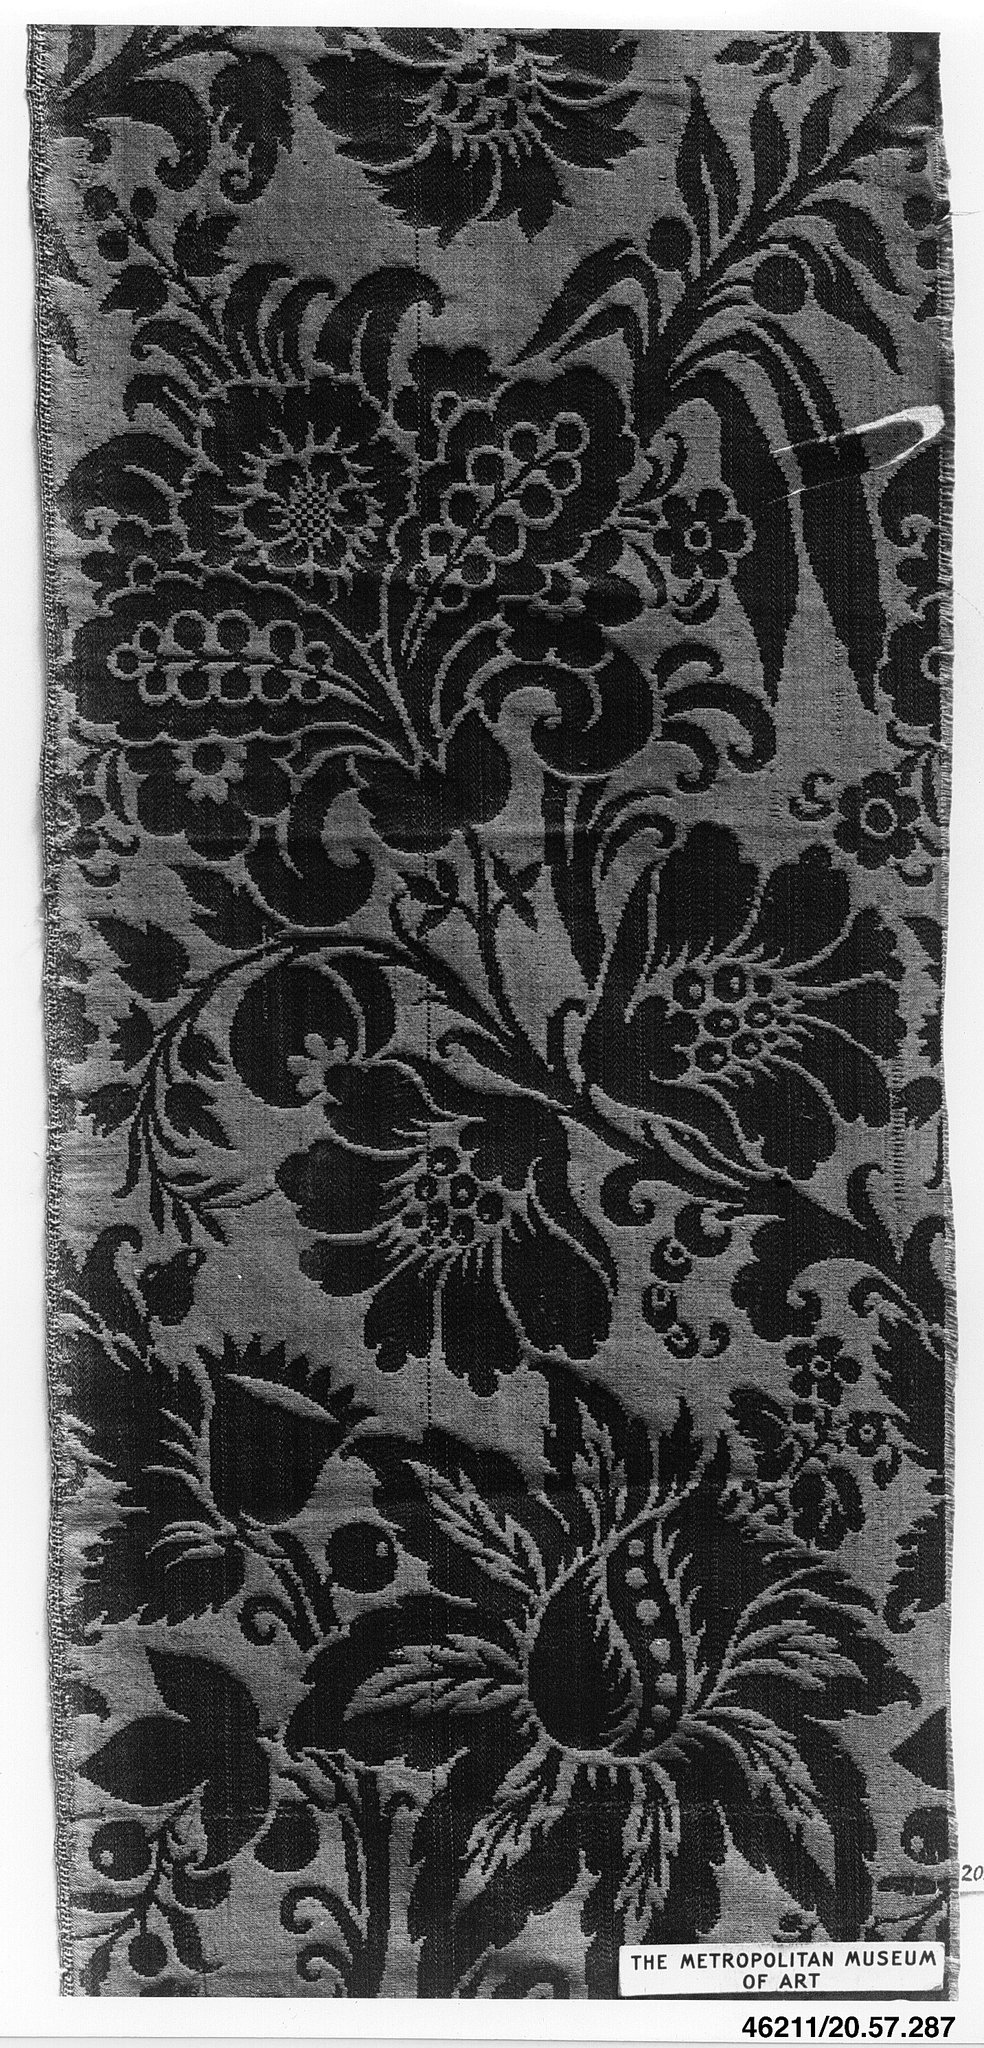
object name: piece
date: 1730-1740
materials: silk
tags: flowers,leaves